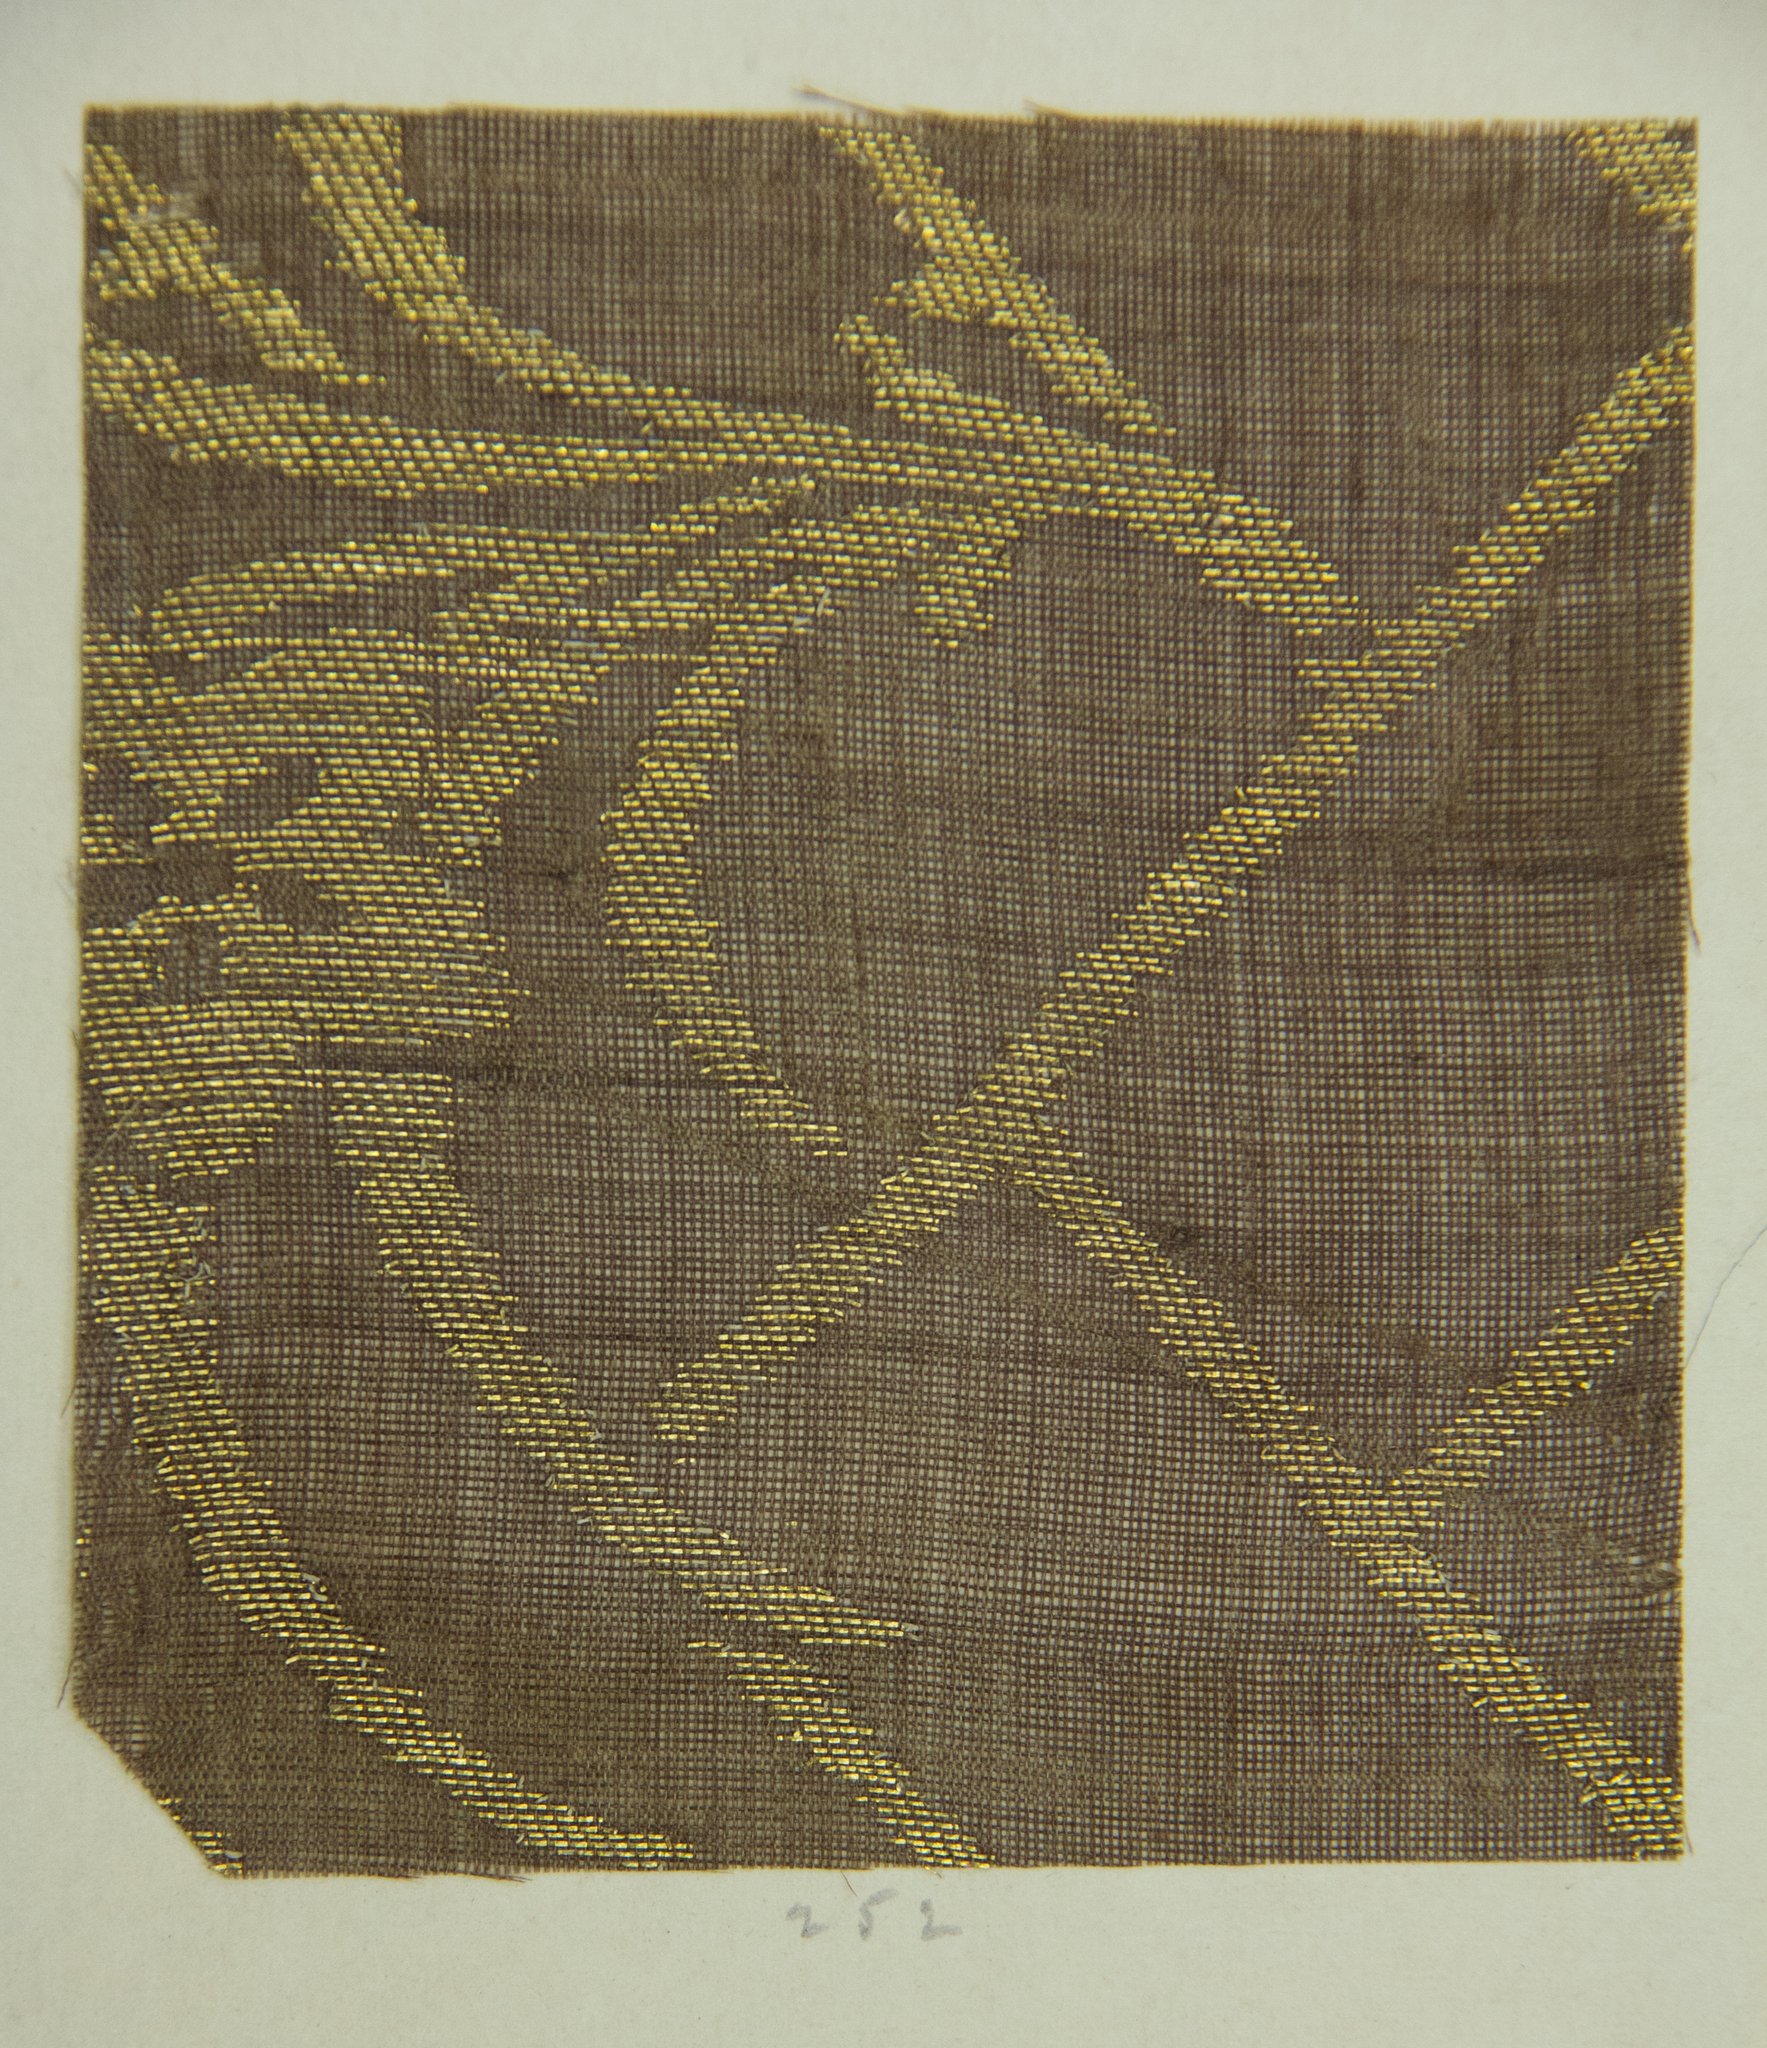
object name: piece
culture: japanese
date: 1701-1800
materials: silk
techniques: compound weave